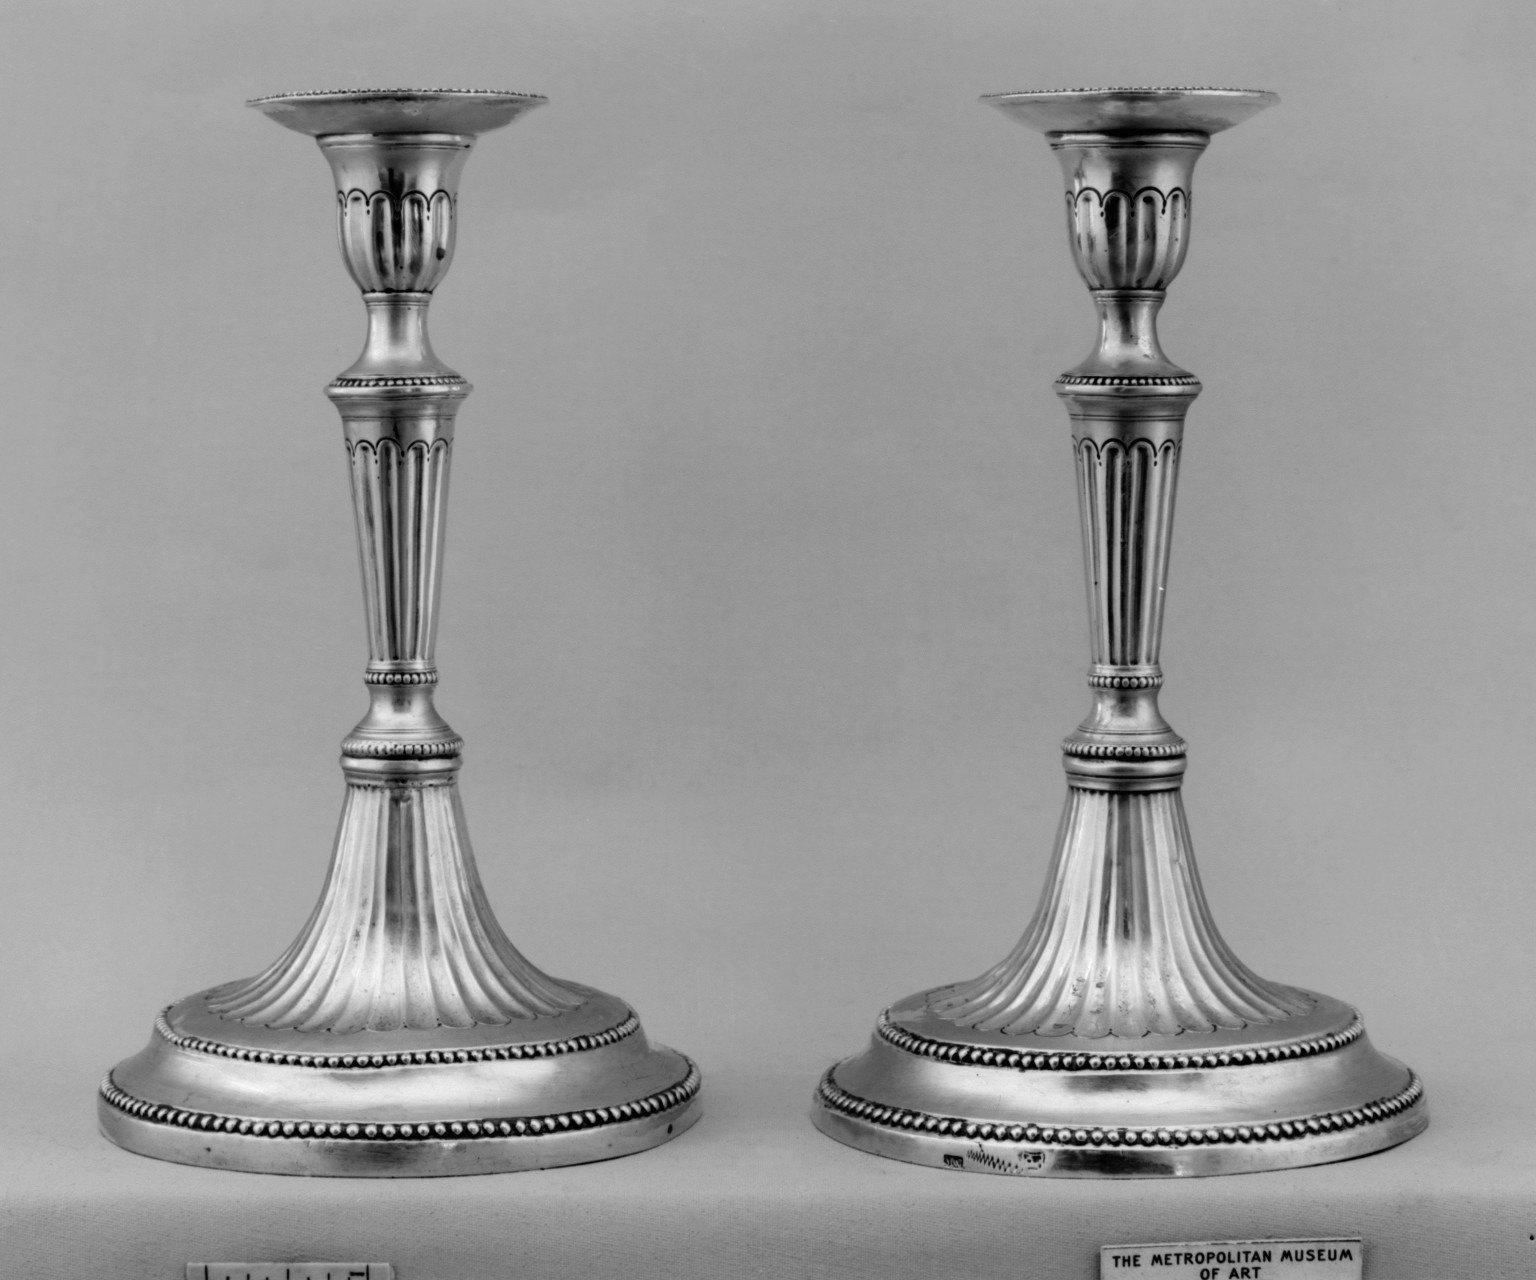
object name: candlestick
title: Candlestick (one of a pair)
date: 1776-1800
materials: silver